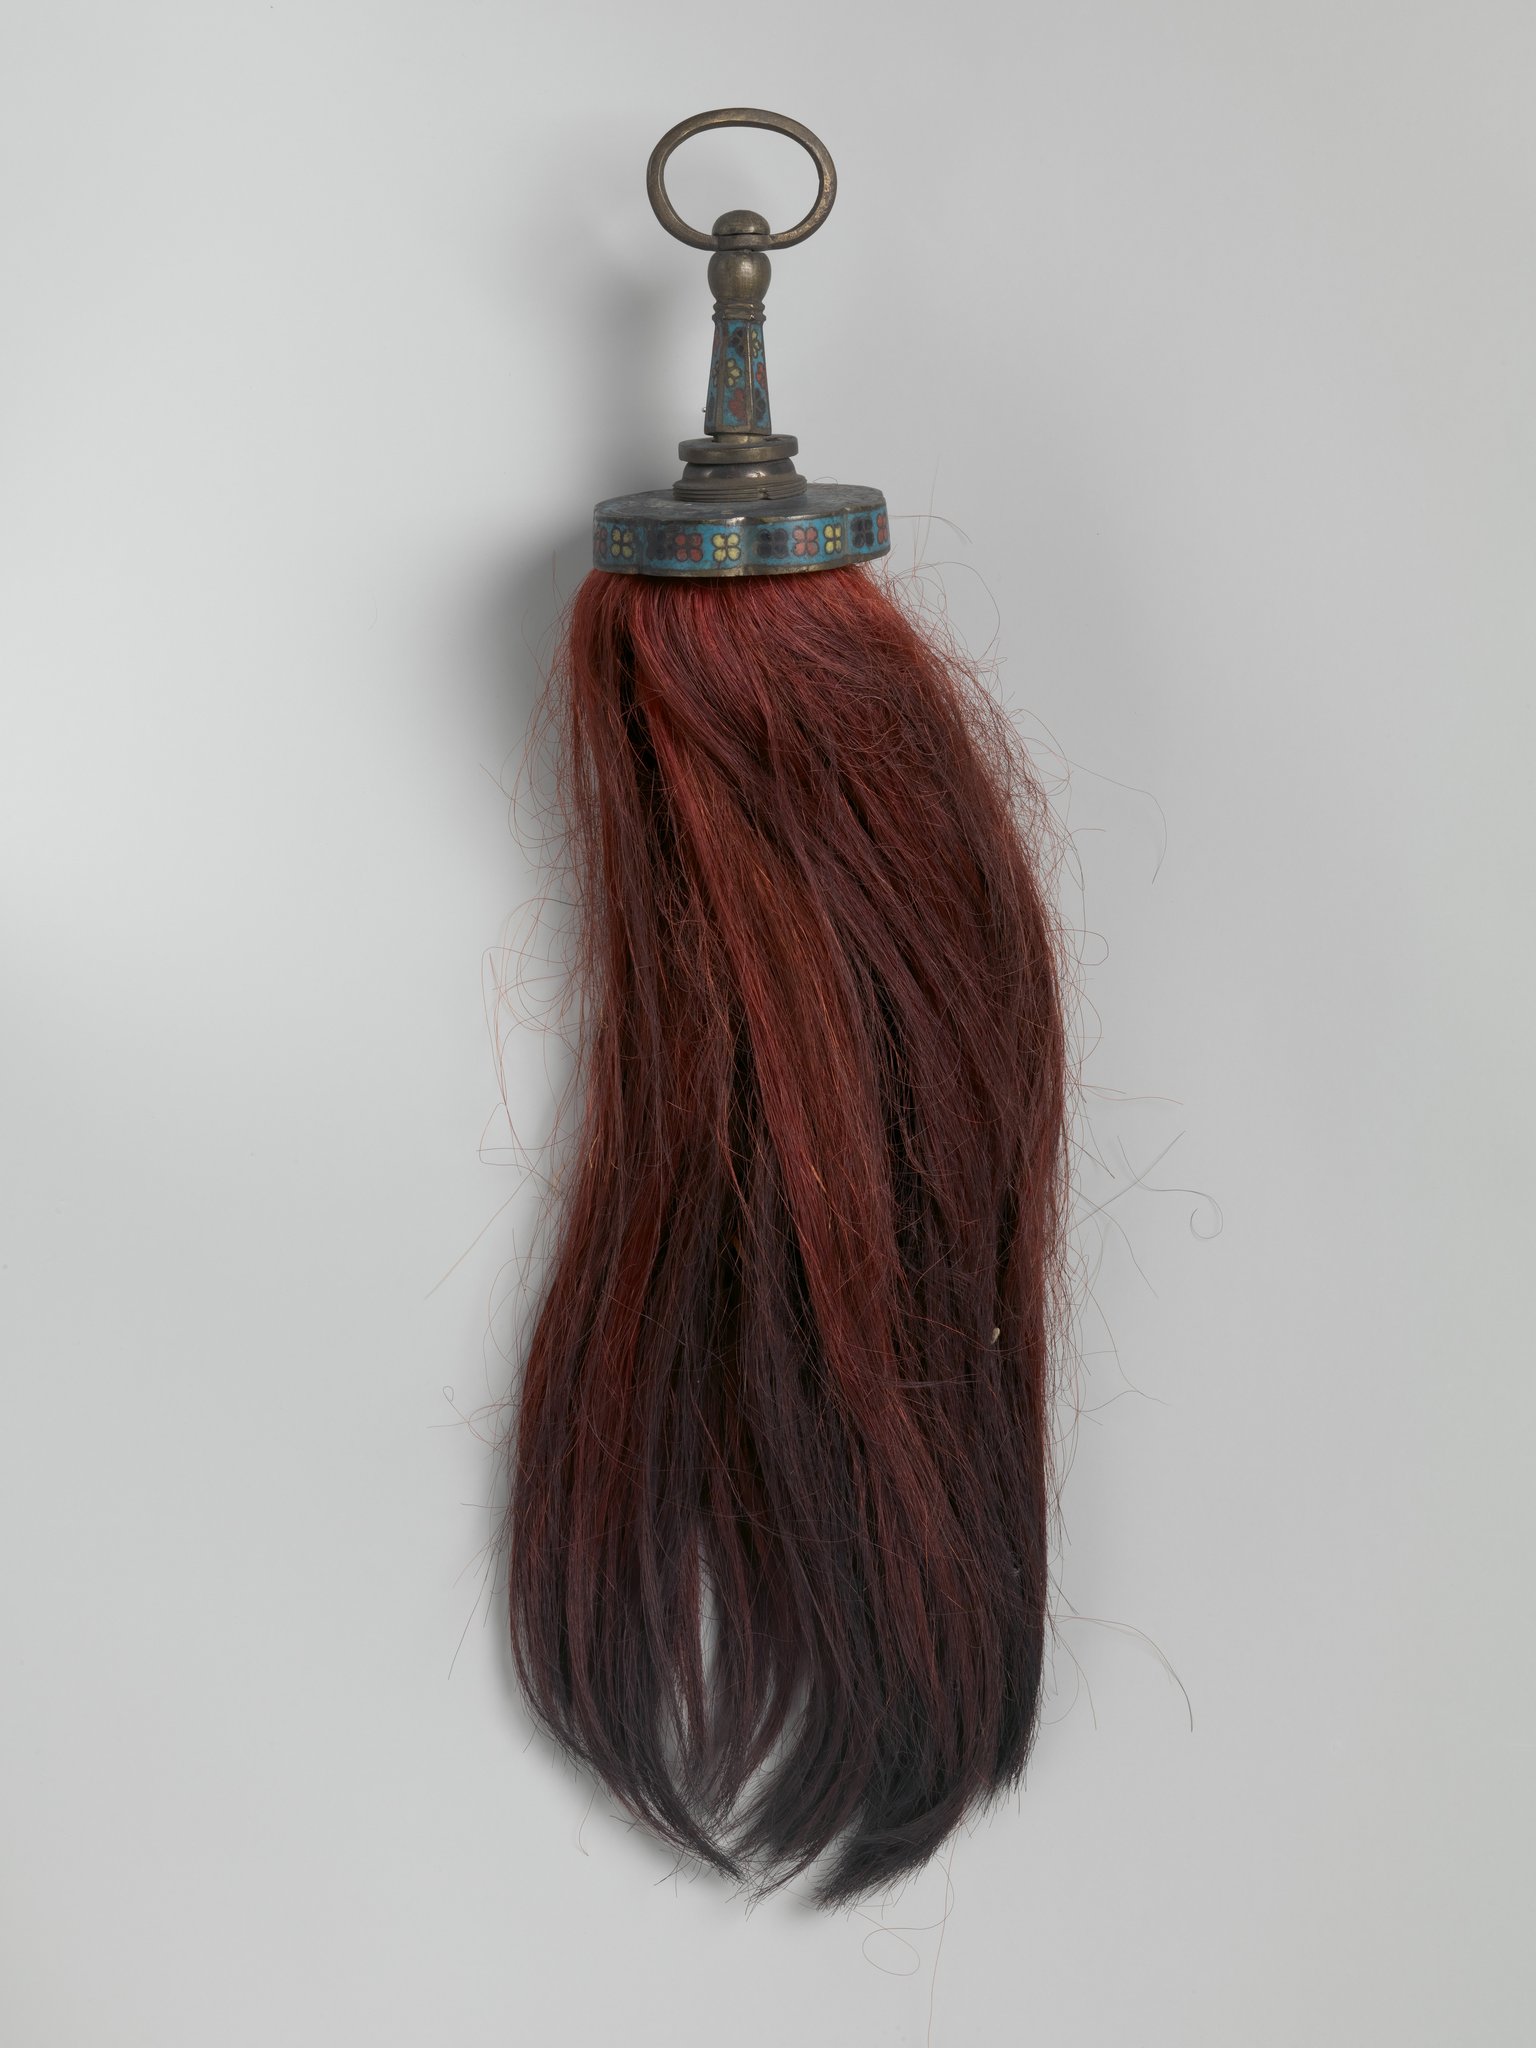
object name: saddle and horse trapping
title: Saddle and Horse Trappings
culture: korean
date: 1501-1900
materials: hair, horn, iron, ivory, silver, textile, wood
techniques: enamel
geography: korea